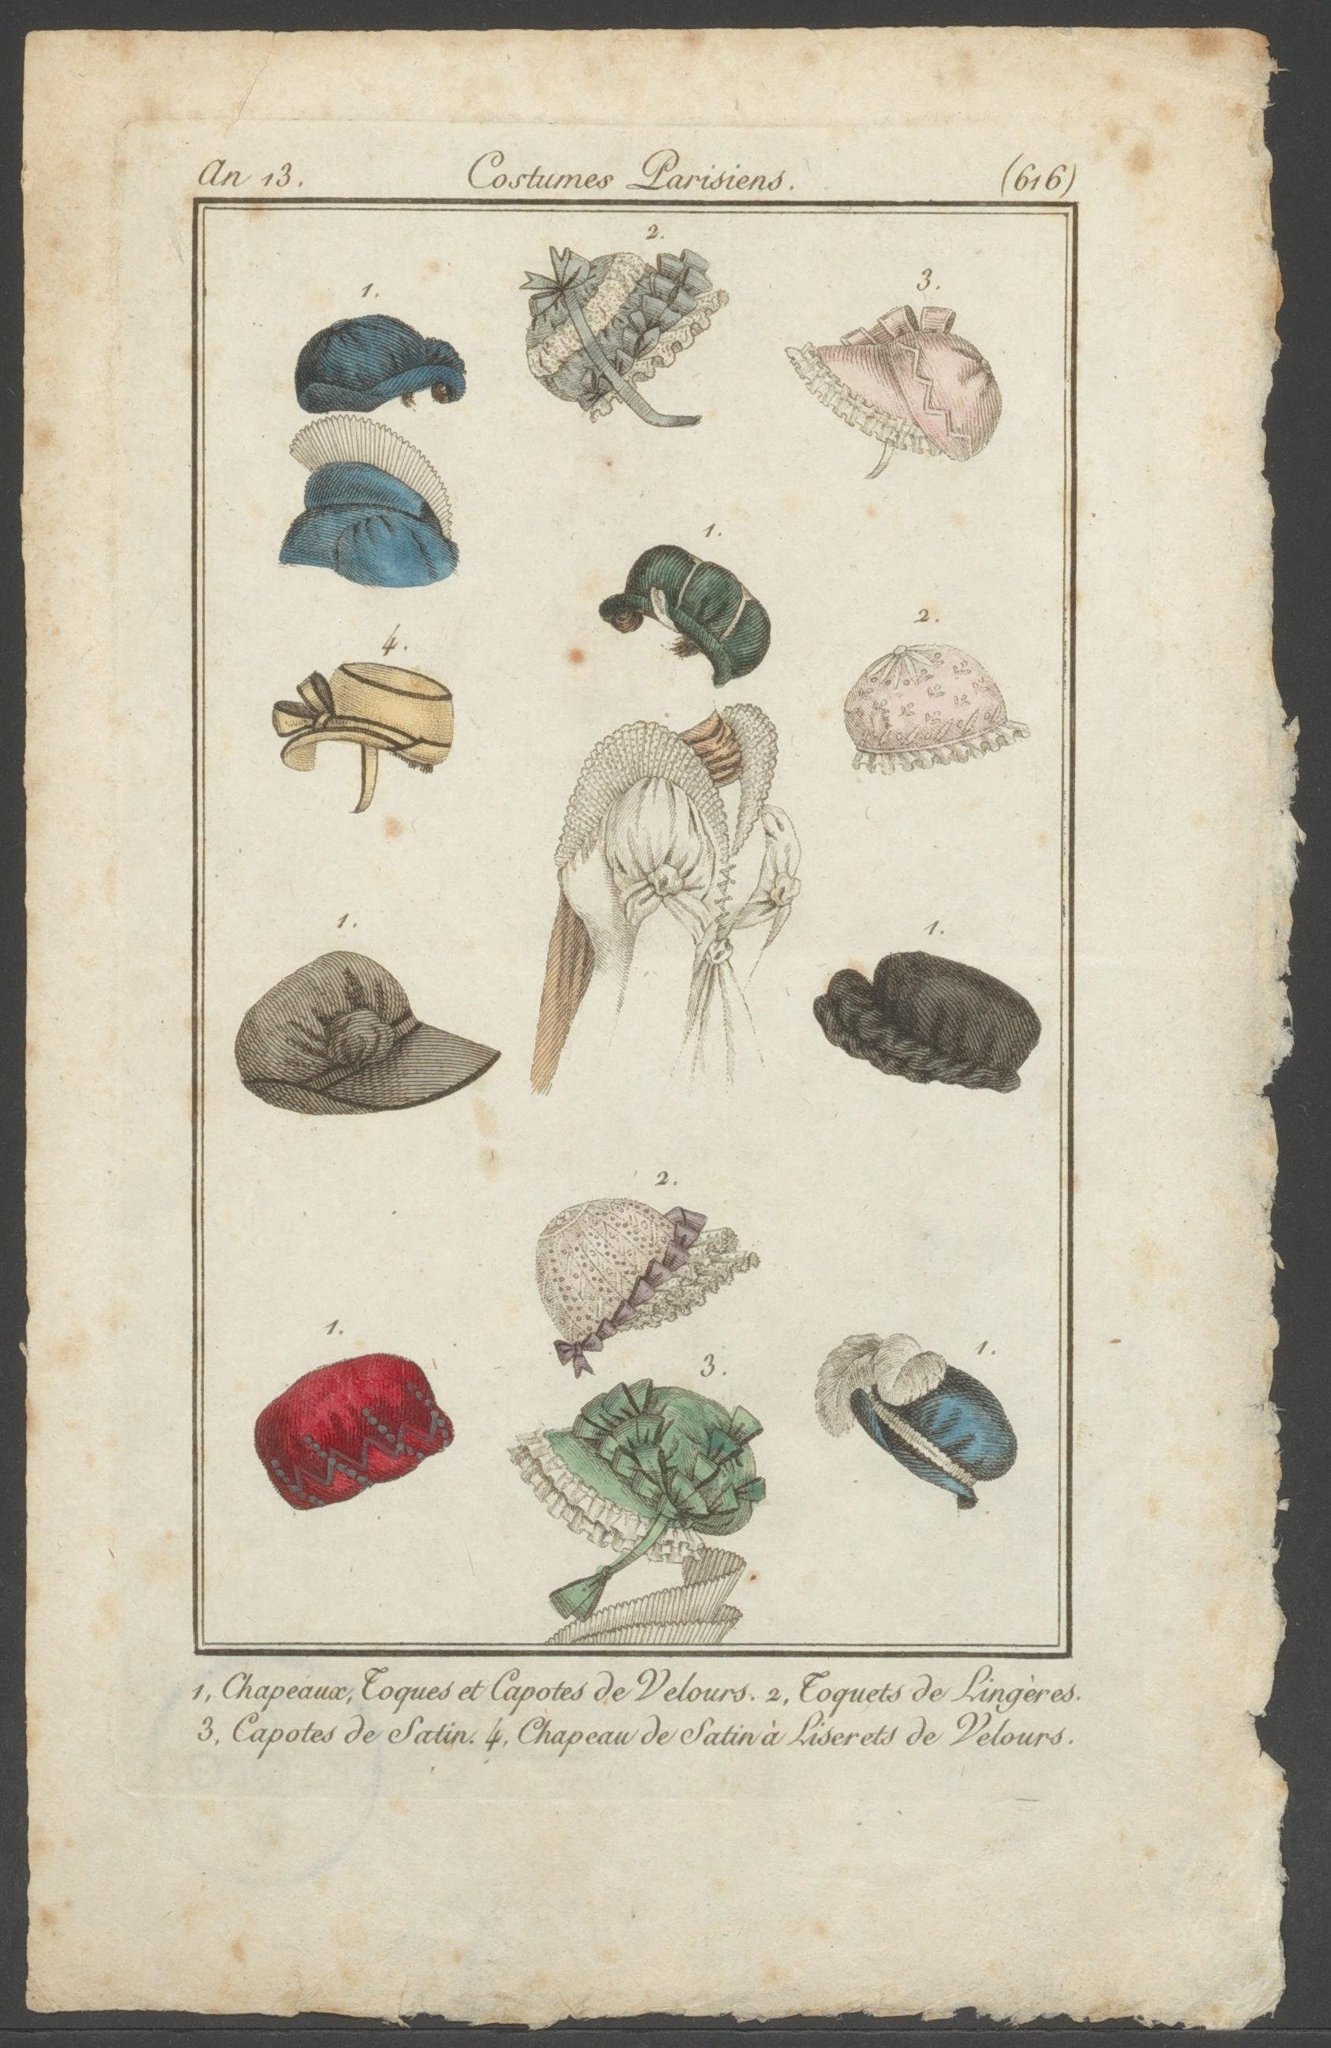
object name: print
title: Twaalf verschillende hoedjes en toques van diverse stoffen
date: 1805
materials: paper, watercolor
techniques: engraving, etching, hand coloring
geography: france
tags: head-gear: toque (+ women's clothes), fashion plates, head-gear: hat (+ women's clothes)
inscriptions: collector's mark, collector's mark: Lugt 1641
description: Twaalf verschillende hoedjes en toques van diverse stoffen. 1. Chapeau, Toques et Capotes de Velours. 2, Toquets de Lingères. 3. Capotes de Satin. 4, Chapeau de Satin à Liserets de Velours. 1. Chapeau, Toques et Capotes de Velours. 2, Toquets de Lingères. 3. Capotes de Satin. Chapeau de Satin à Liserets de Velours. Onderwerpsrubrieken binnen de Atlas Zeden en Gewoonten: De Kleeding, Modeplaten.